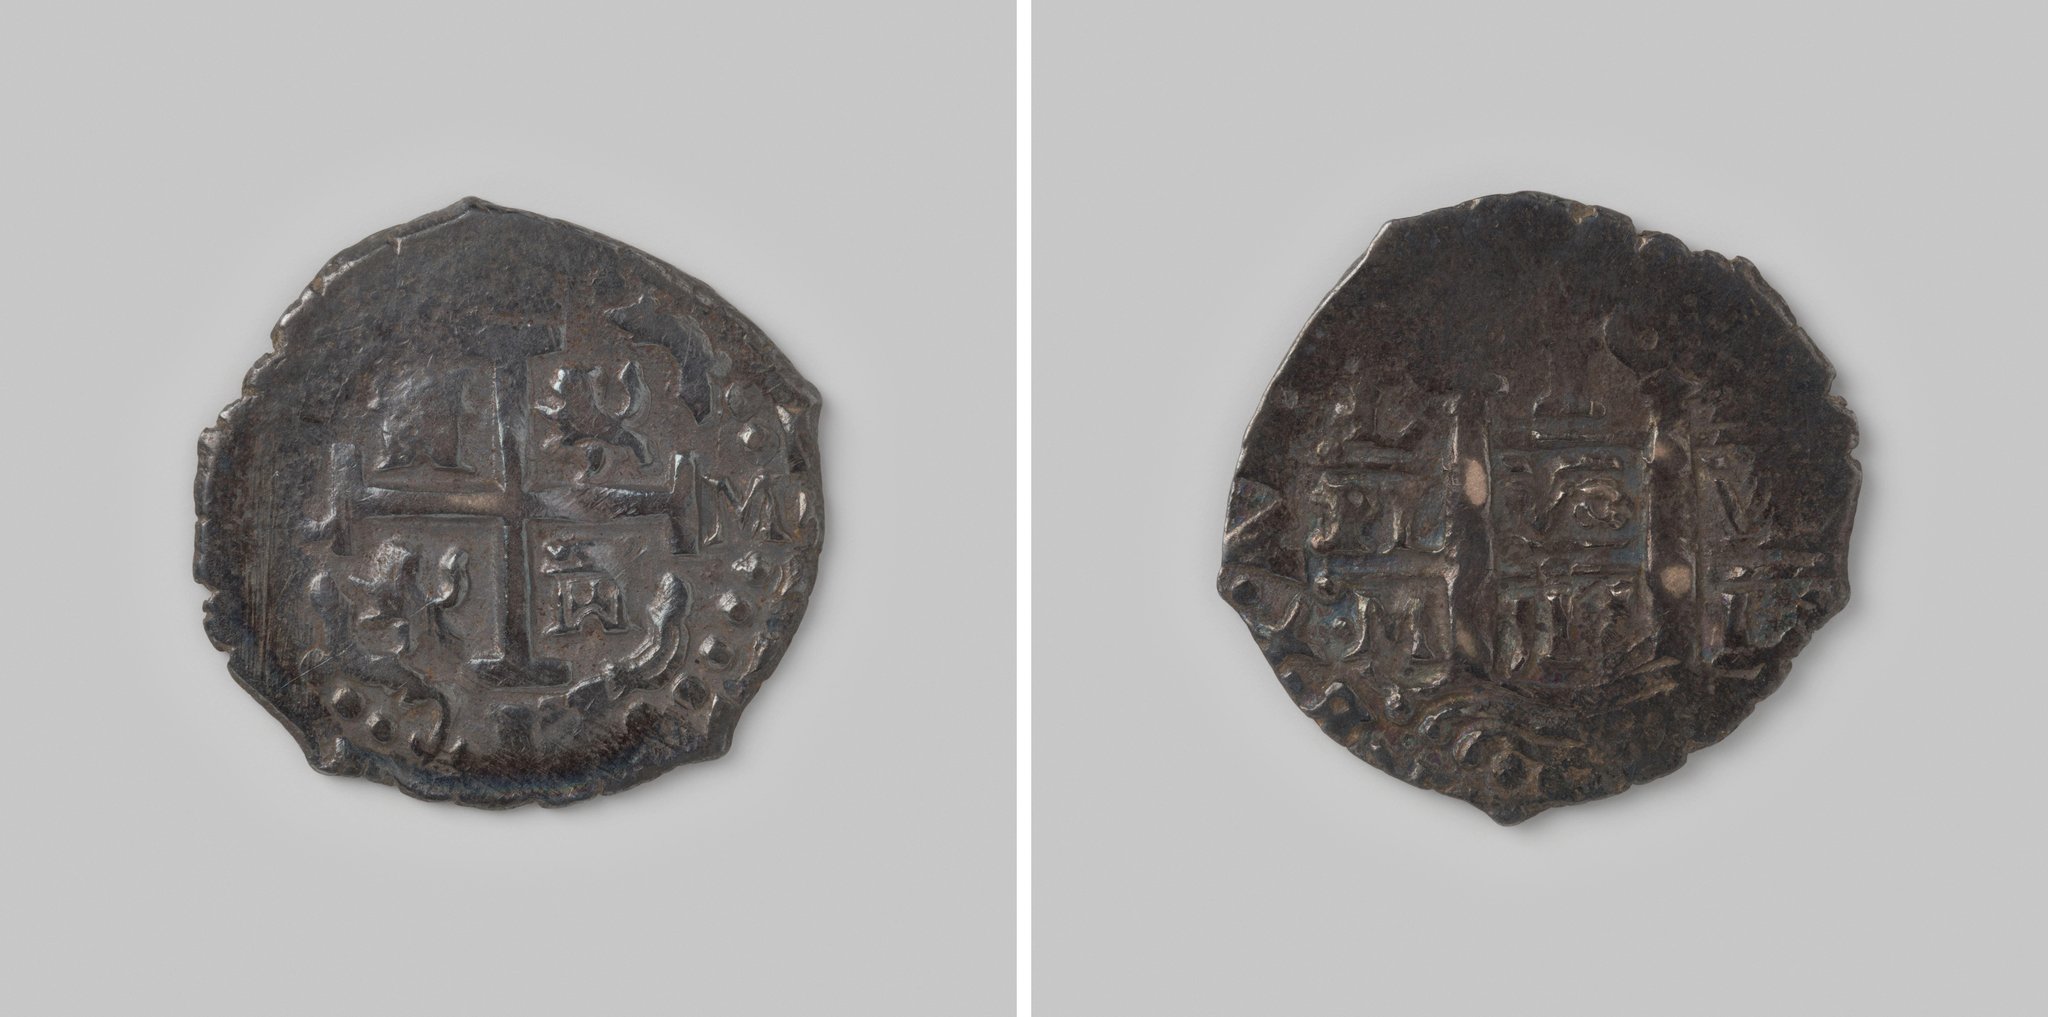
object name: real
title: Peru, Philips V, reaal,1711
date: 1711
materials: silver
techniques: striking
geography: lima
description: Zilveren munt uit ruw muntplaatje. Voorzijde: binnen vierpas gelijkbenig herkruist kruis met in de hoeken afwisseld een kasteel en een leeuw. Keerzijde: tussen twee uit zee oprijzende zuilen, waarop versiering, in drie regels waarde-aanduiding: I, opschrift en jaartal: 711. Daartussen tweemaal muntplaats-aanduiding: LM [=Lima].